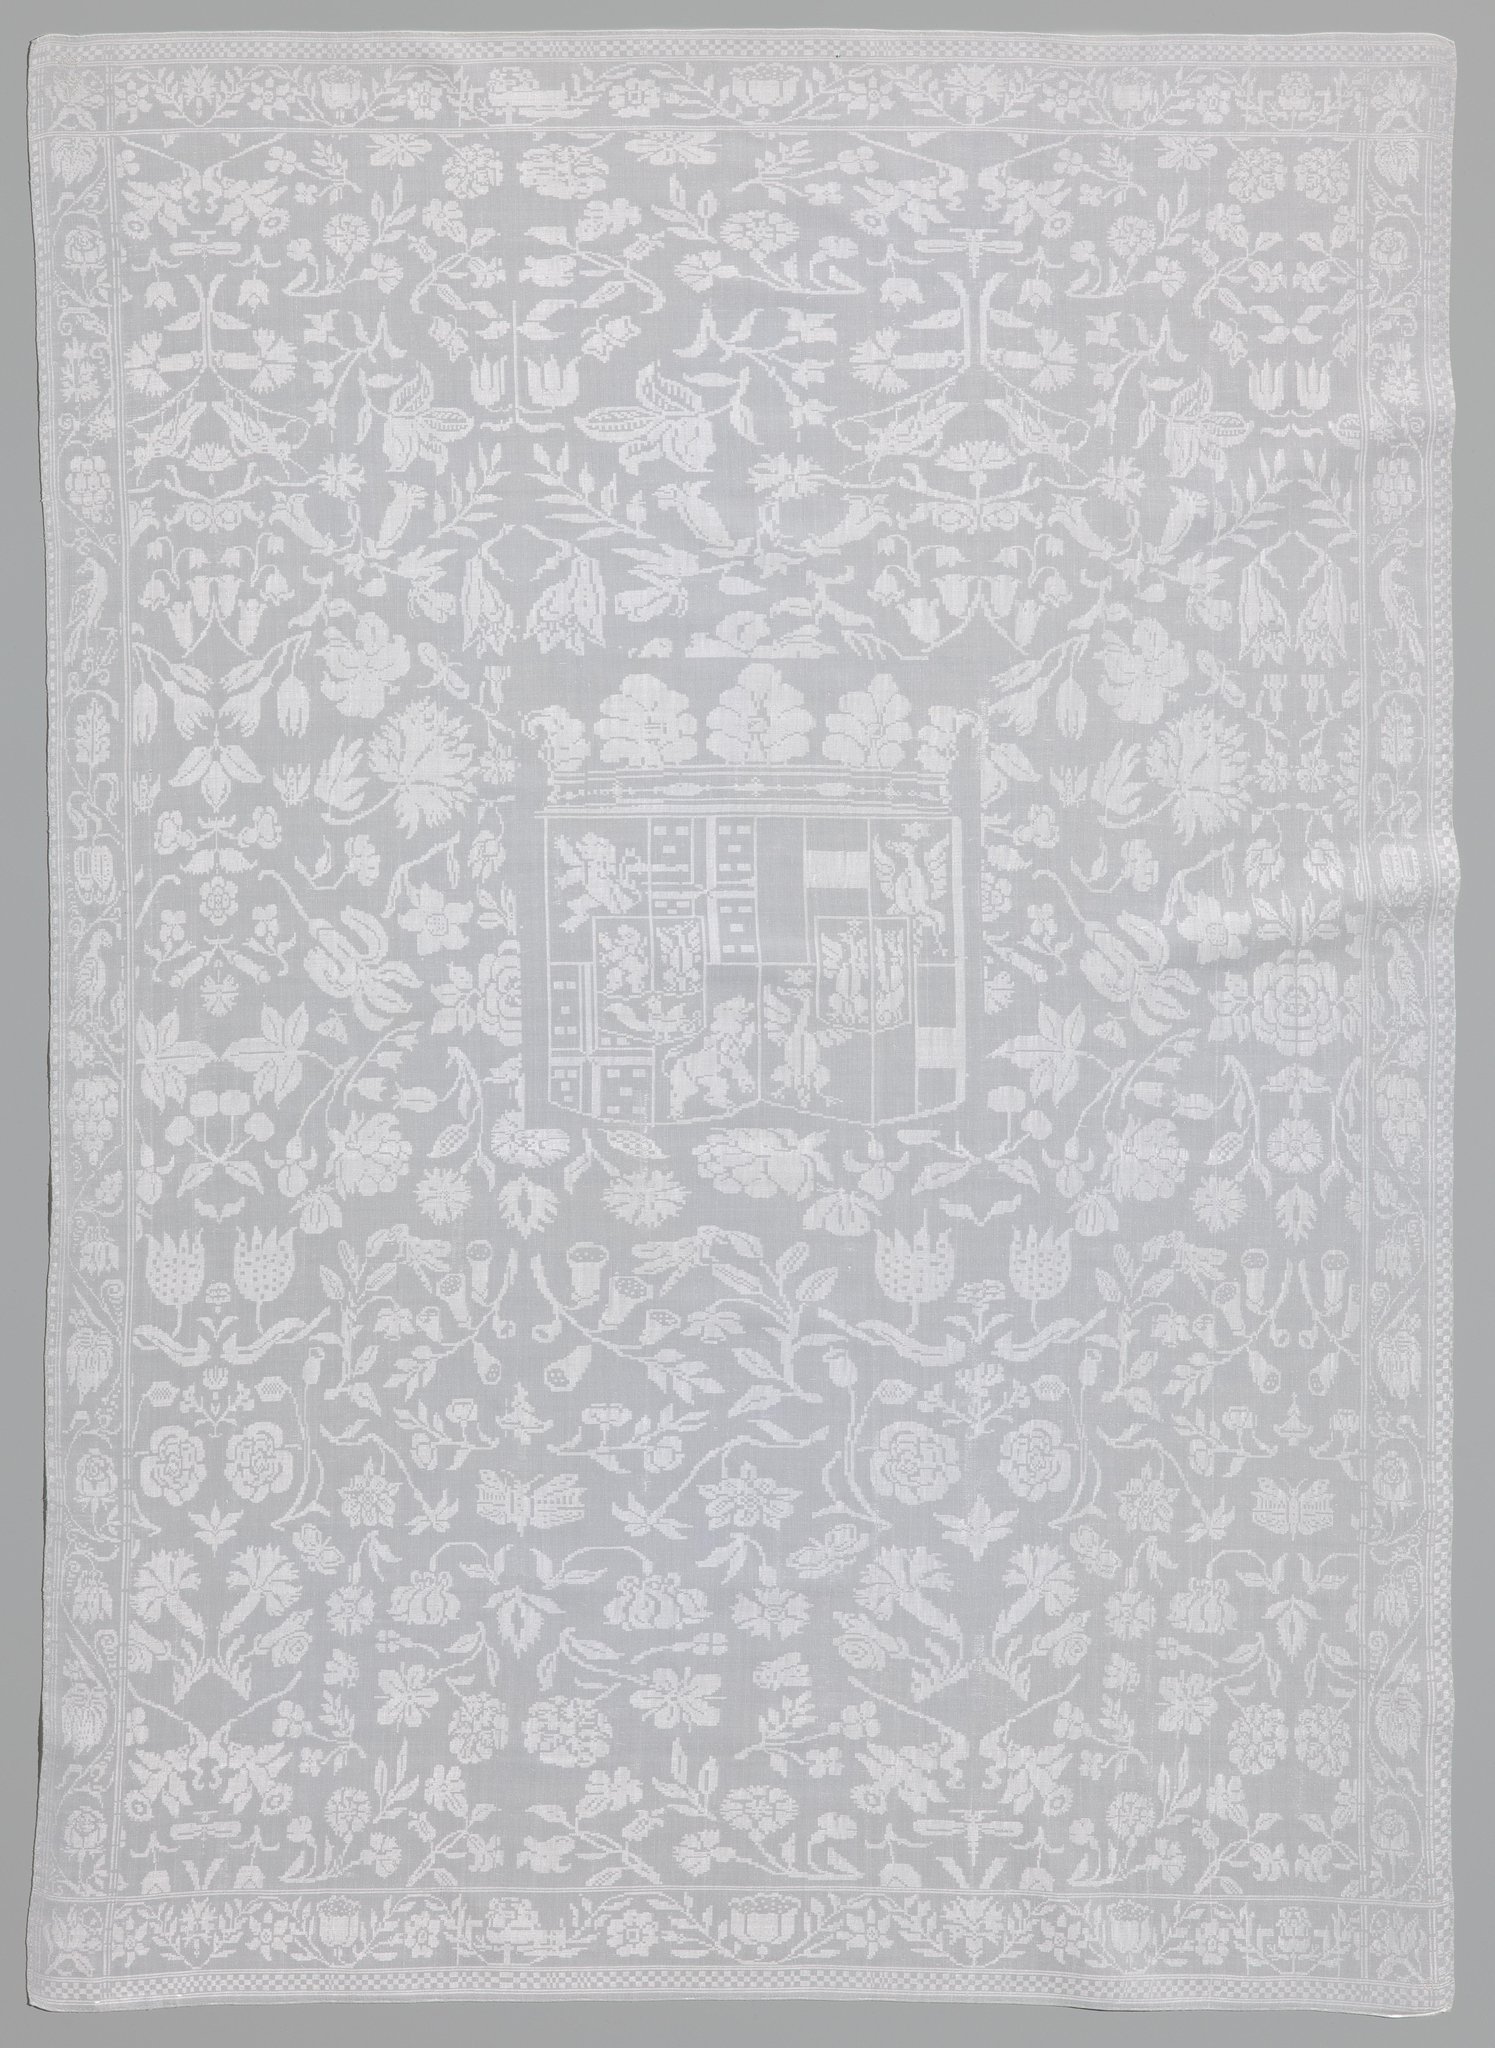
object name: woven material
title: Servet van wit linnendamast met gekoppelde wapens Von Inn- und Kniphausen en Van Ewsum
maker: Anonymous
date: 1665-1670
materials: linen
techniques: damask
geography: northern netherlands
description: Servet van wit linnendamast met bloempatroon rondom de gekoppelde wapens Von Inn- und Kniphausen en Van Ewsum. Gemerk": kroon LE 17.